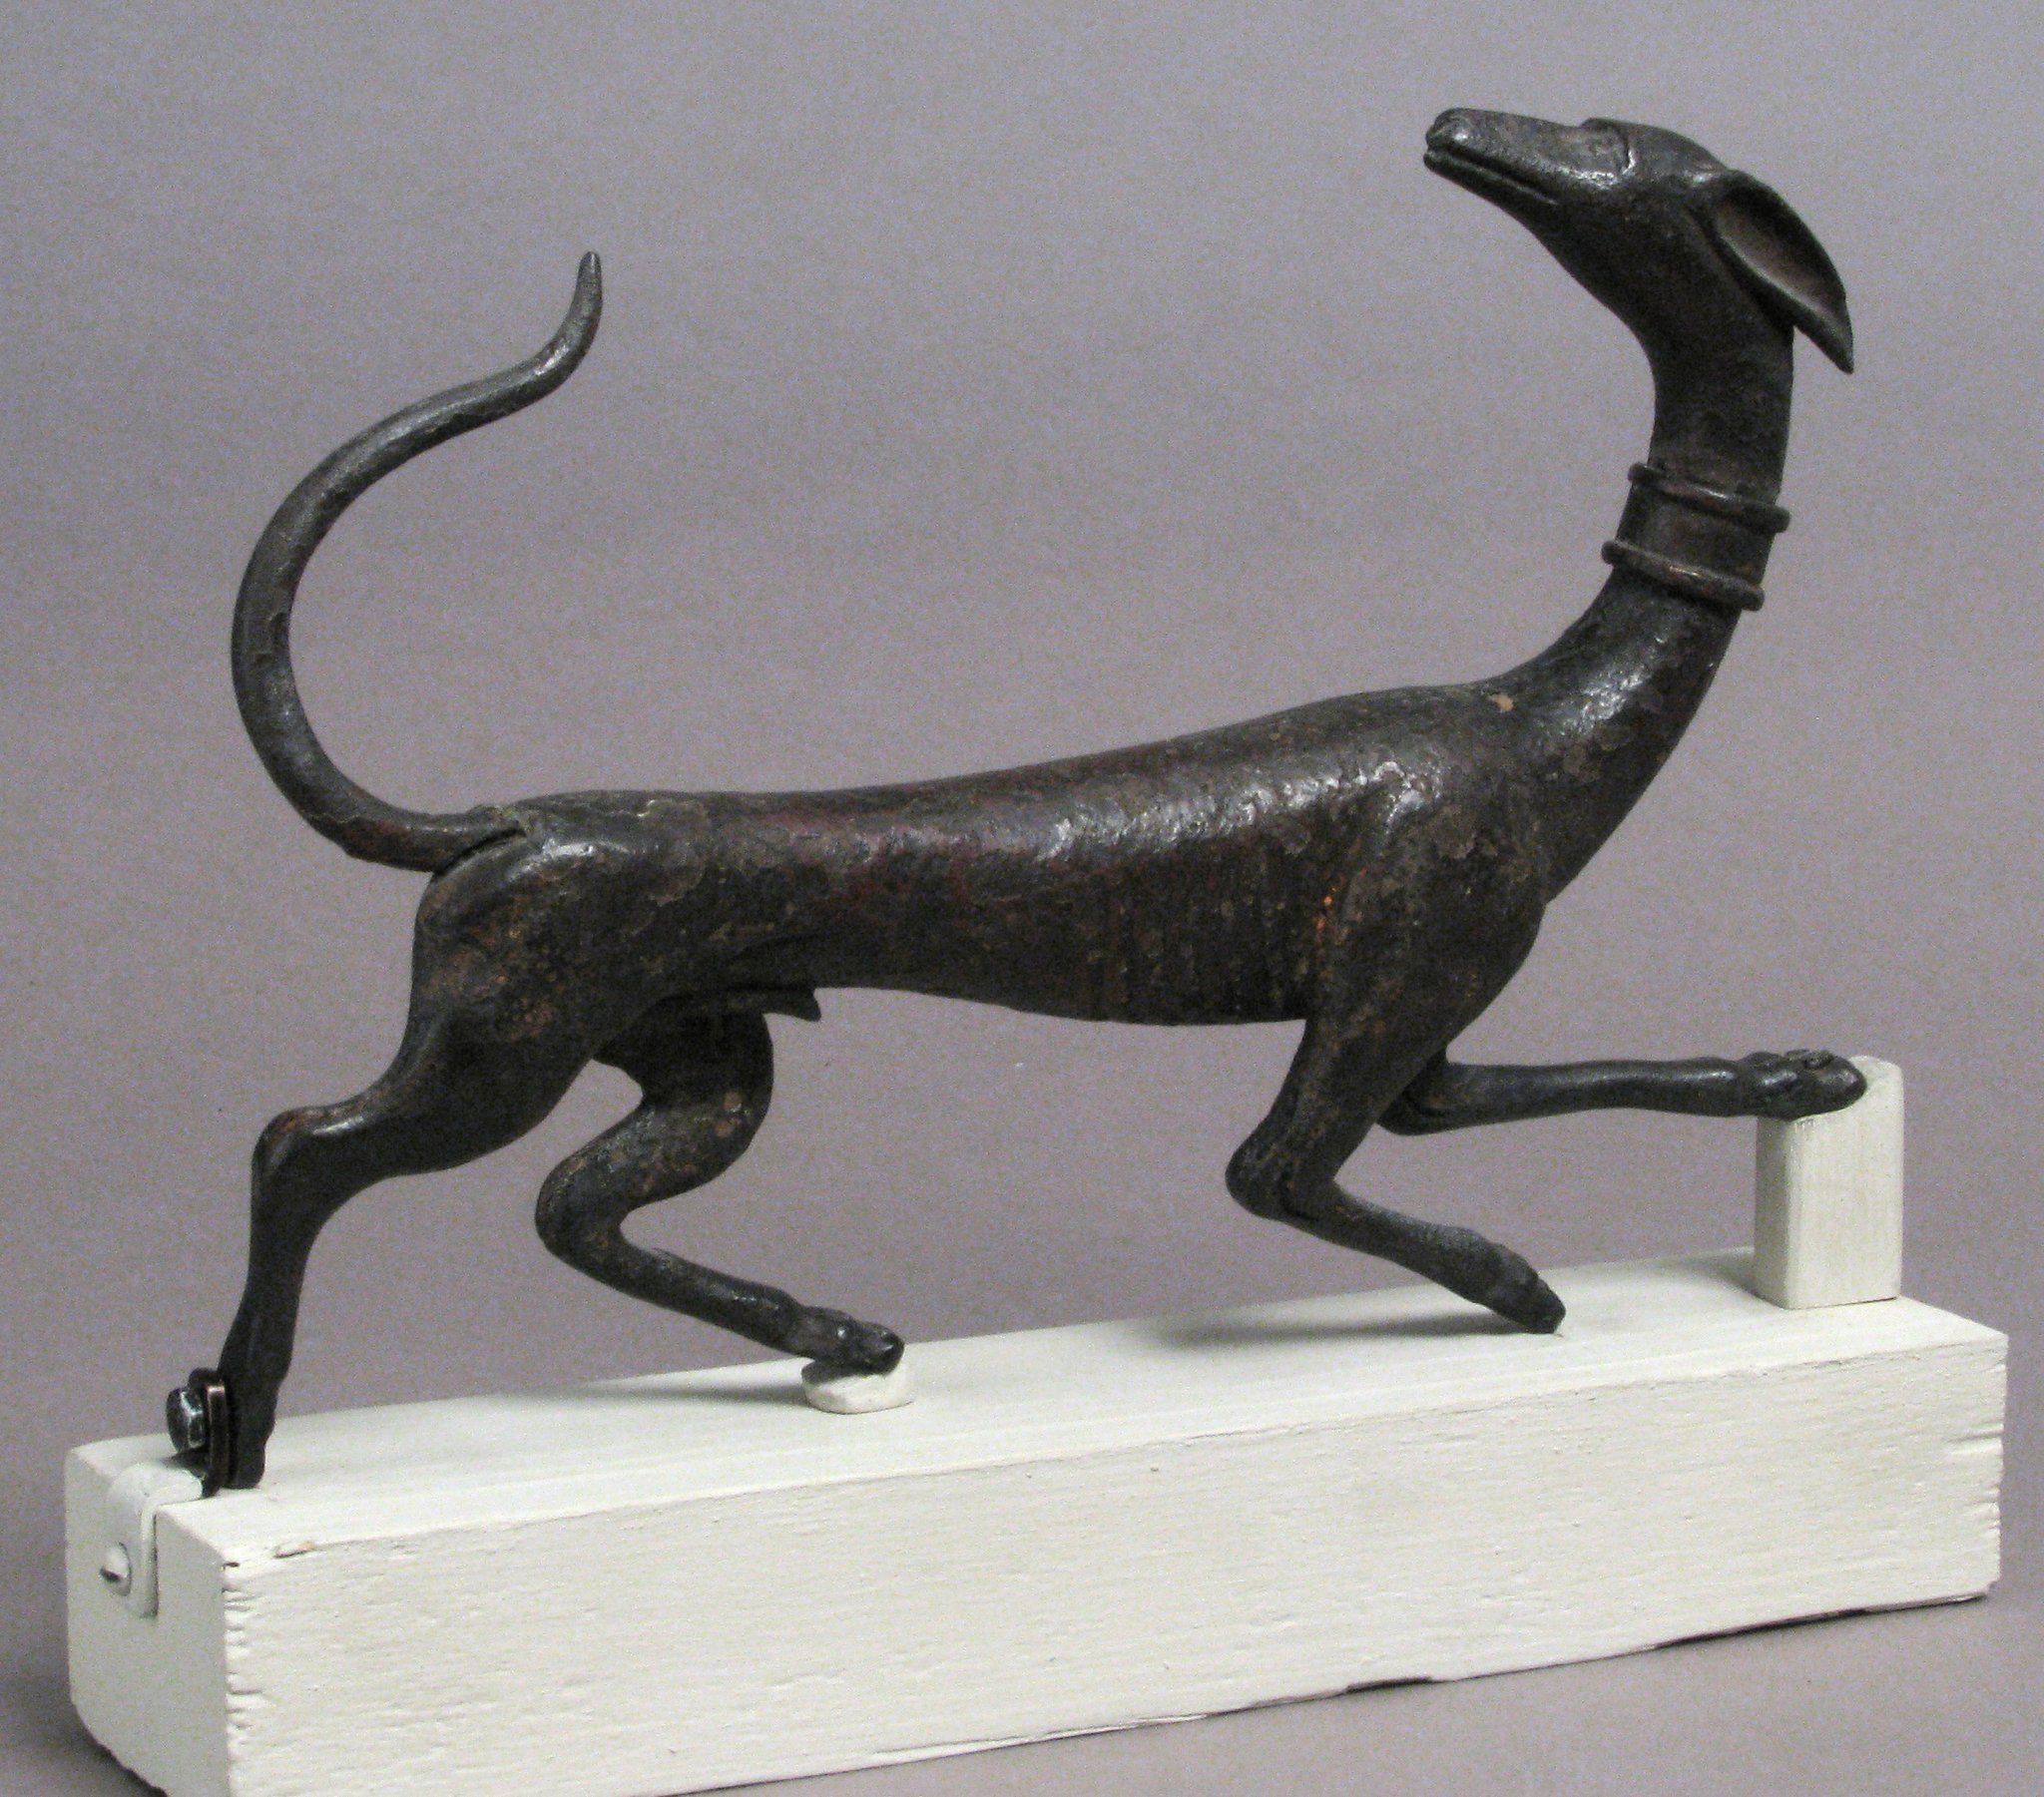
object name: figure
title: Hunting Dog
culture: european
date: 1401-1600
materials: iron